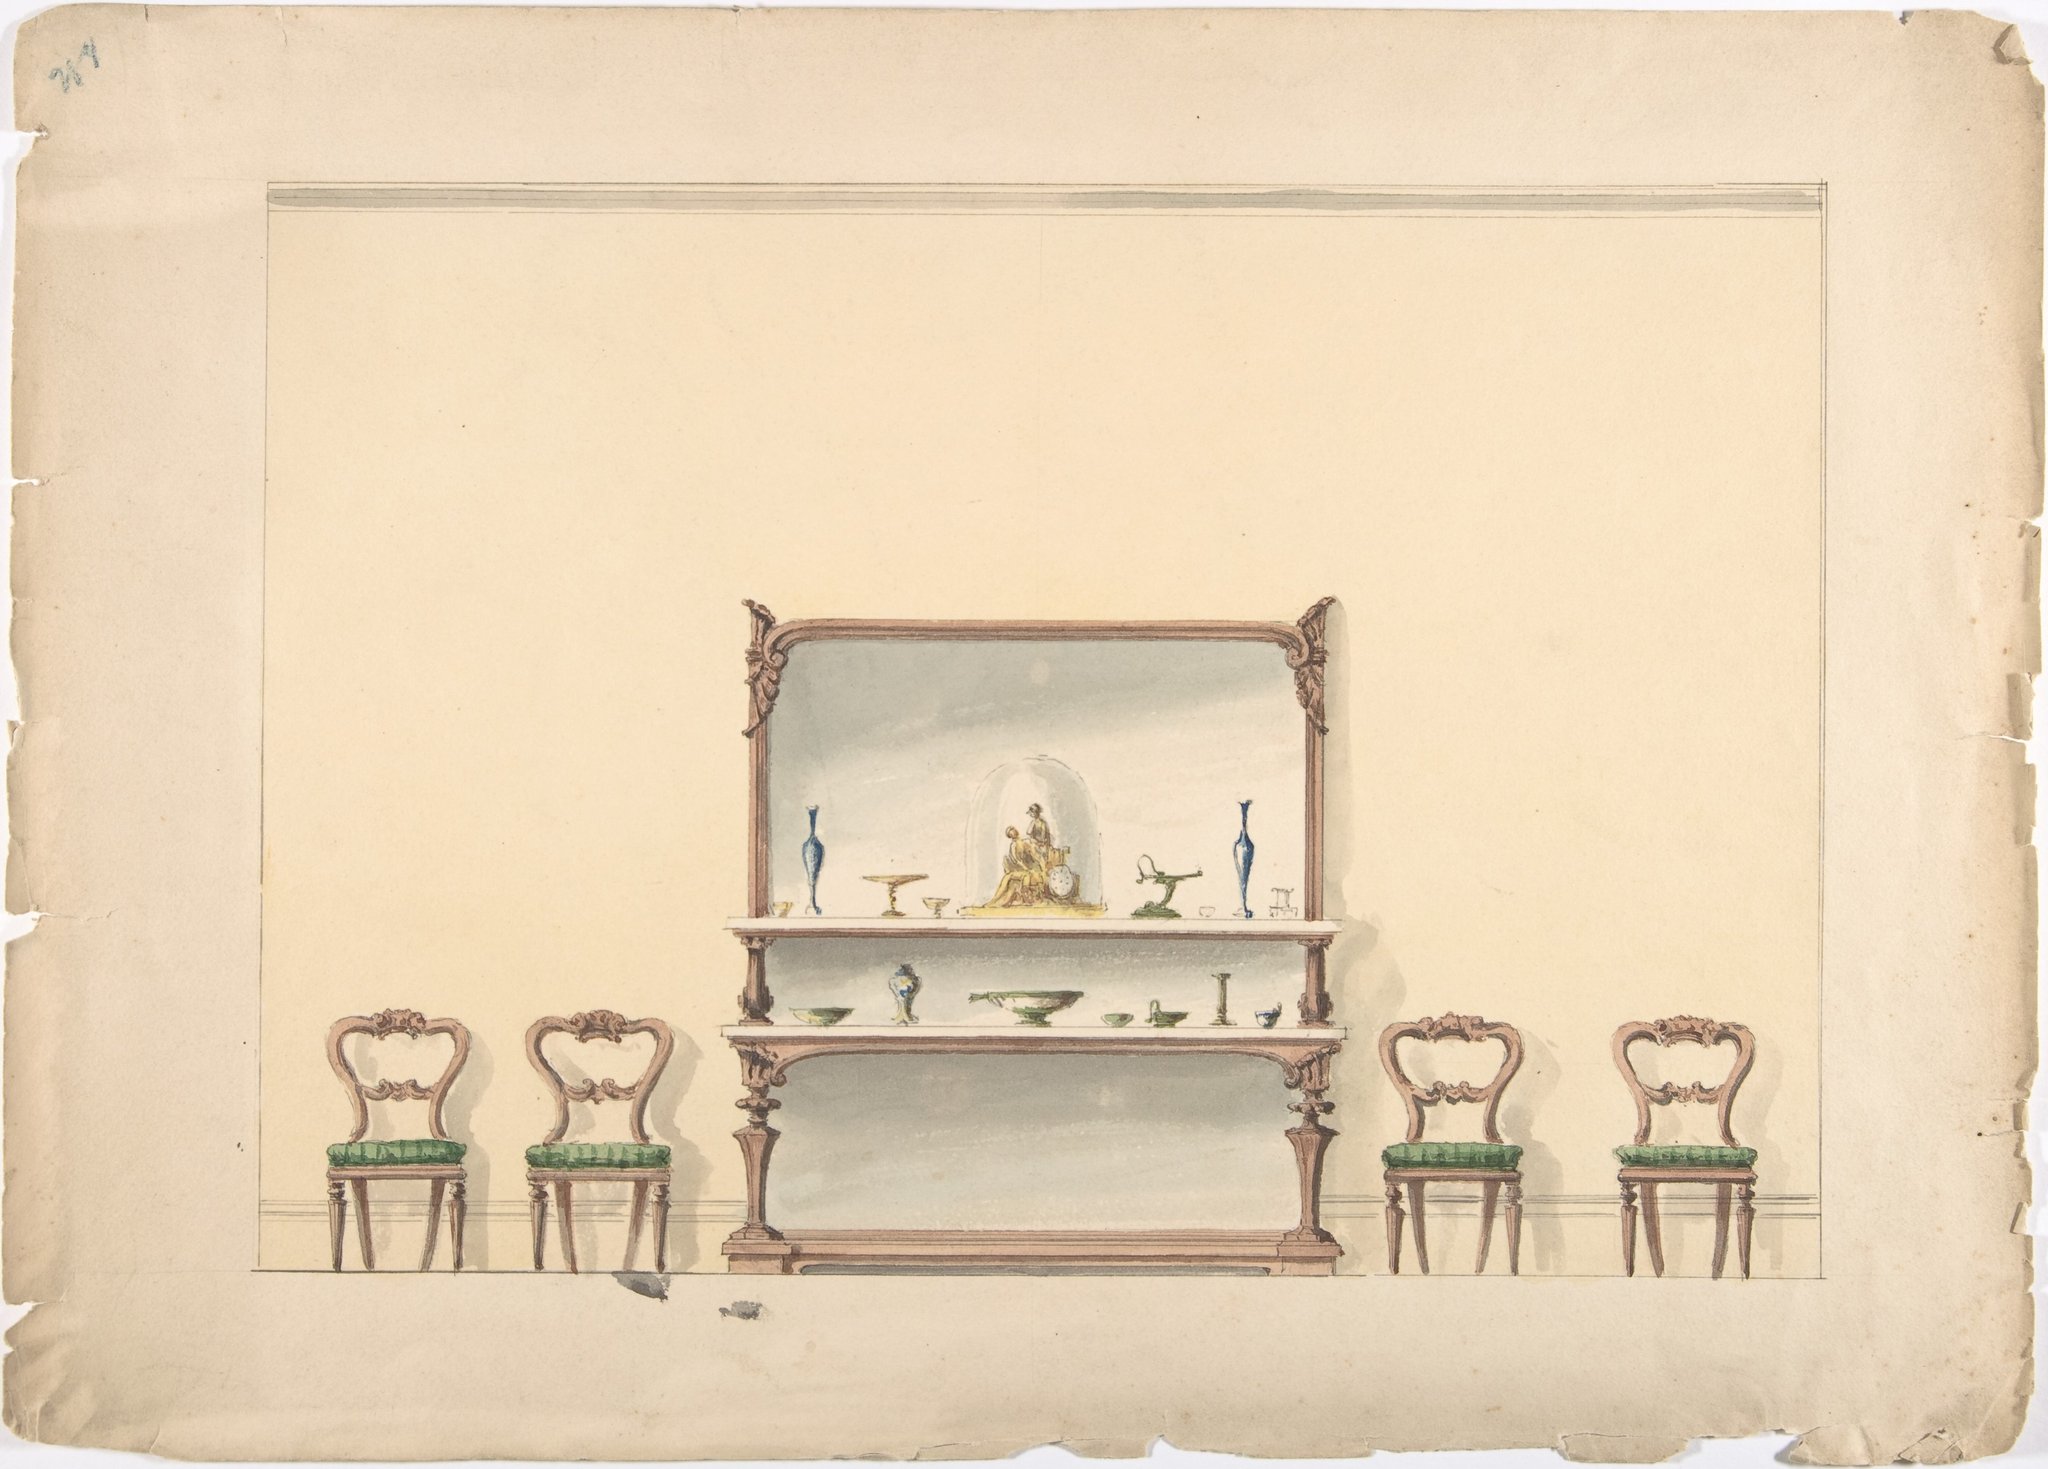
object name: drawing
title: Design for a Mirrored, Marble-topped Sideboard and Four Chairs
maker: anonymous, british, 19th century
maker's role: artist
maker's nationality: british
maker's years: 1800-1900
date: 1801-1833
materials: ink, watercolor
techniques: brush, pen, wash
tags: furniture,chairs,mirrors